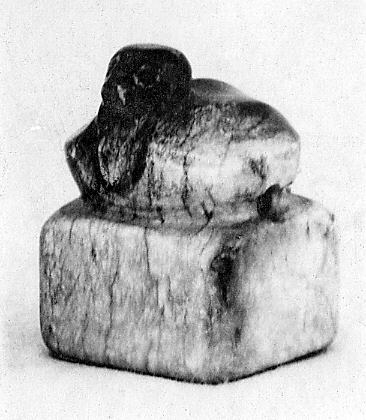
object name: seal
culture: chinese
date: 206 BCE-220 CE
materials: jade